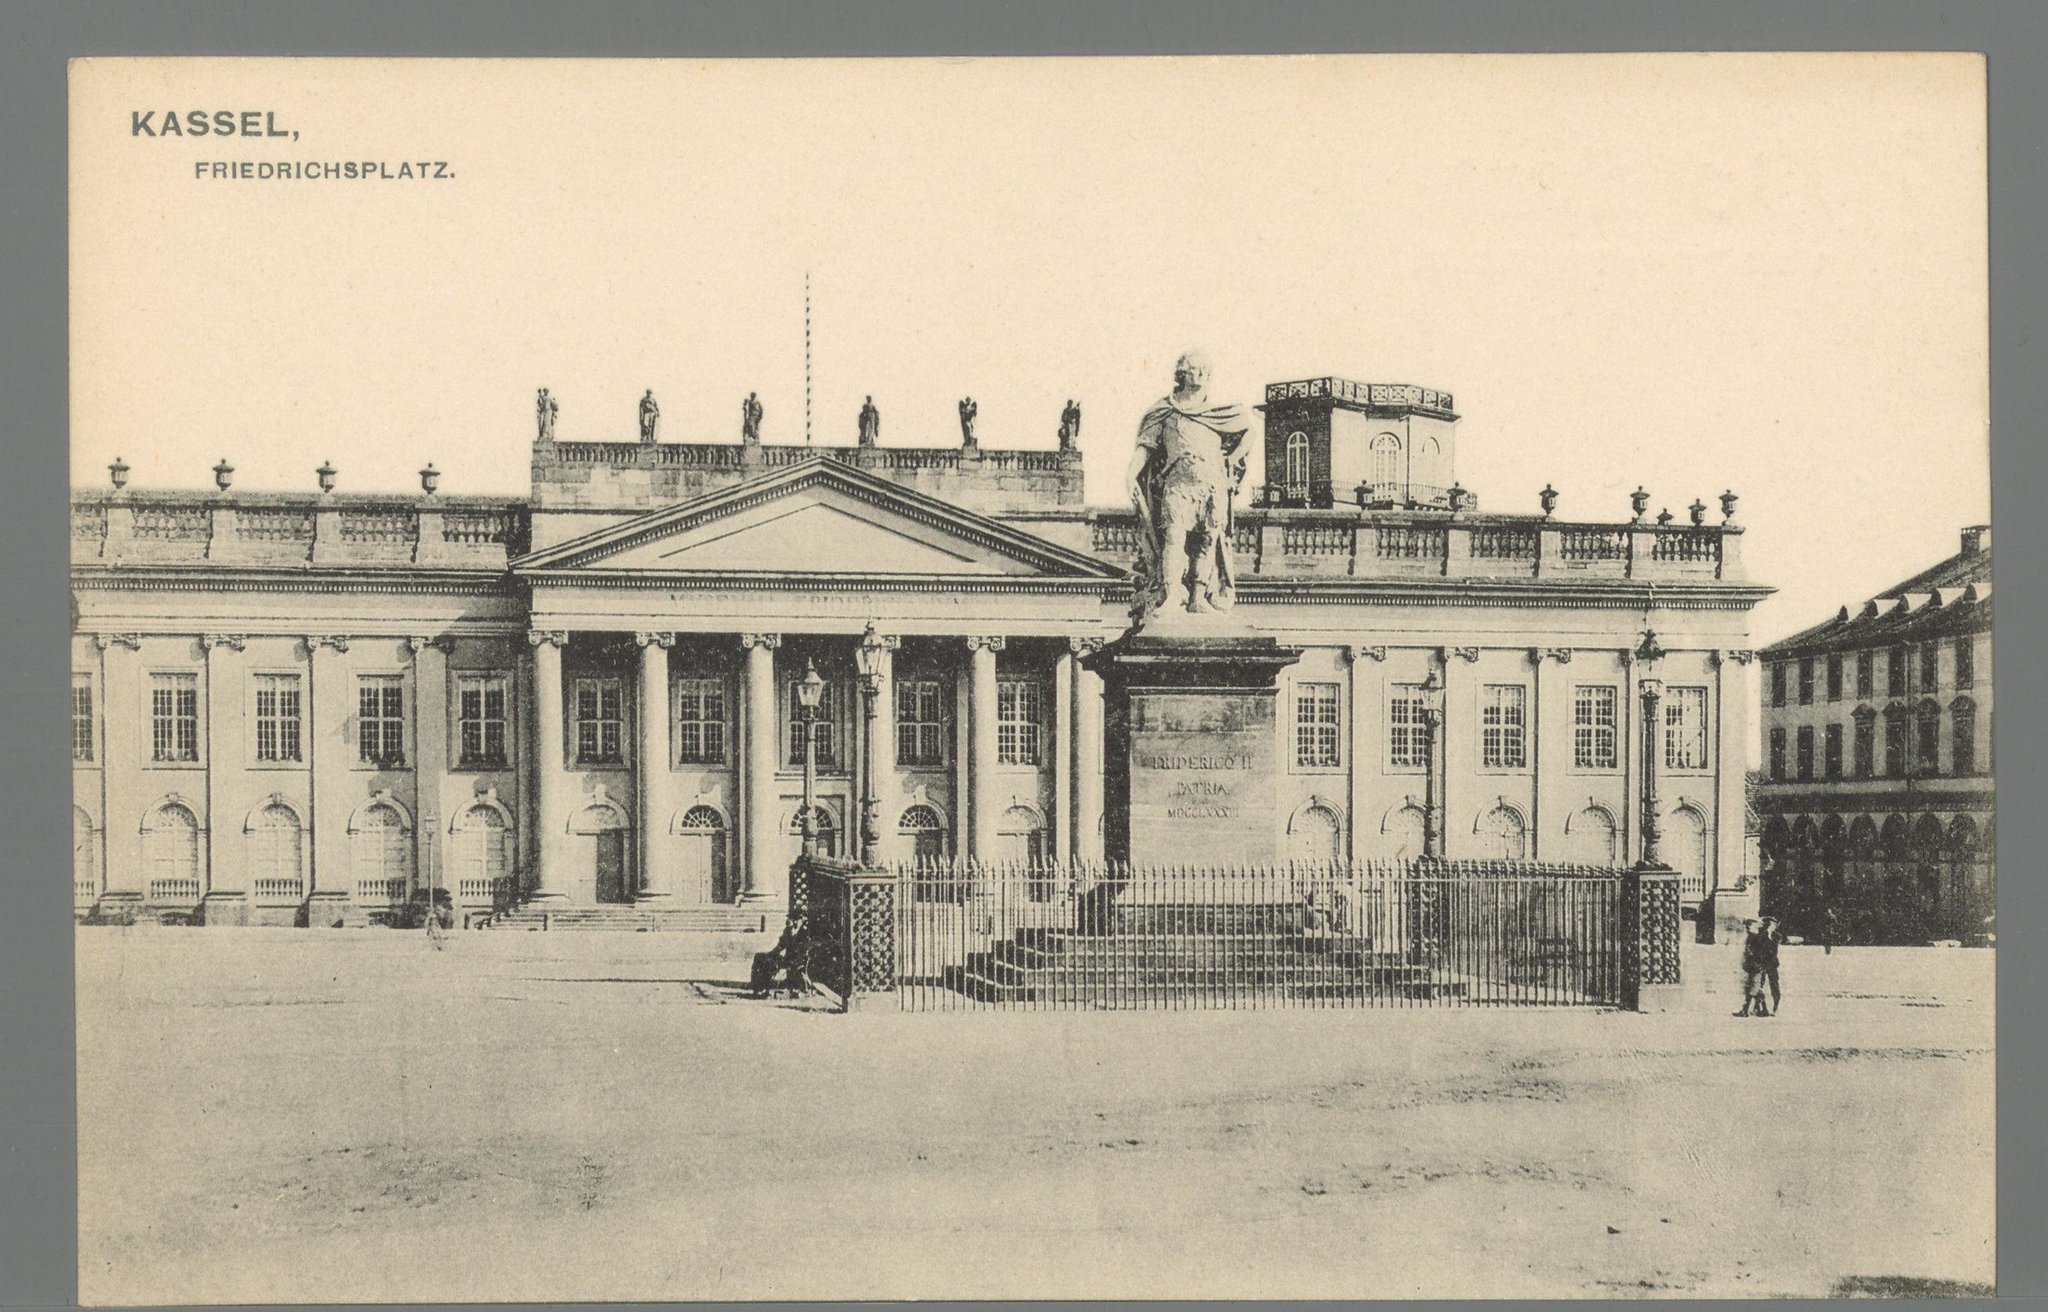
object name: photomechanical print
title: Kassel, Friedrichsplatz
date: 1908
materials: cardboard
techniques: photograph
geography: kassel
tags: square, place, circus, etc., monument, statue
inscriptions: date